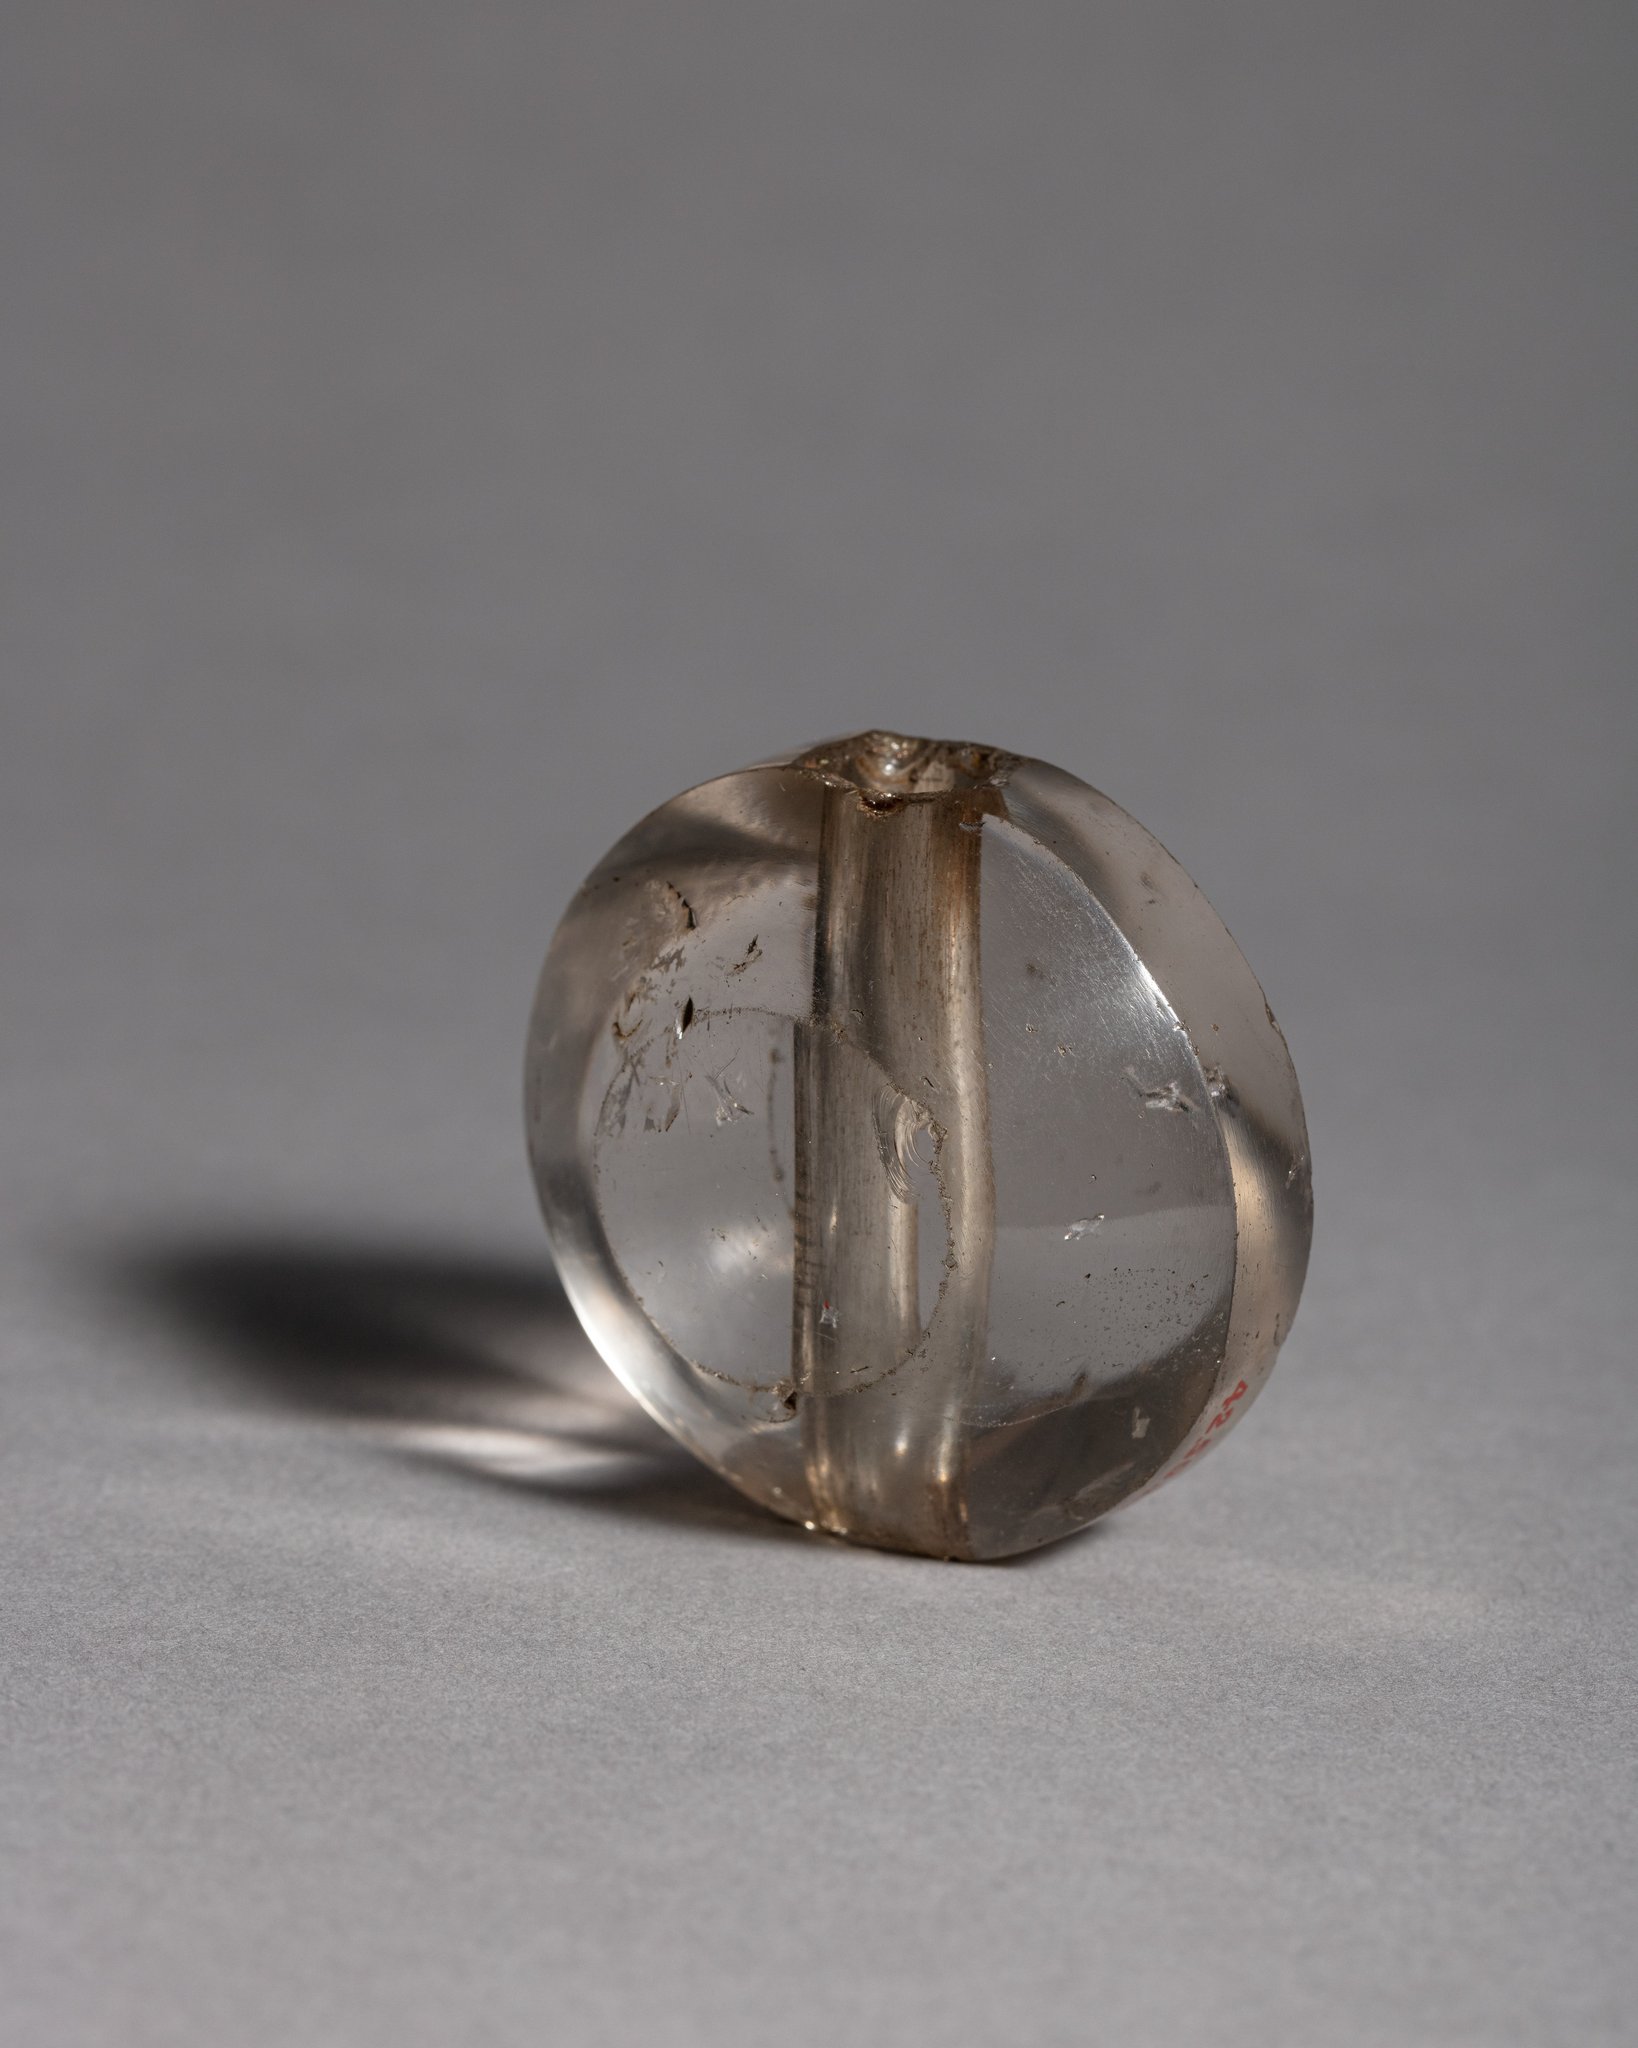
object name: sword pommel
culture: italian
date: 1400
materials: quartz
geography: italy